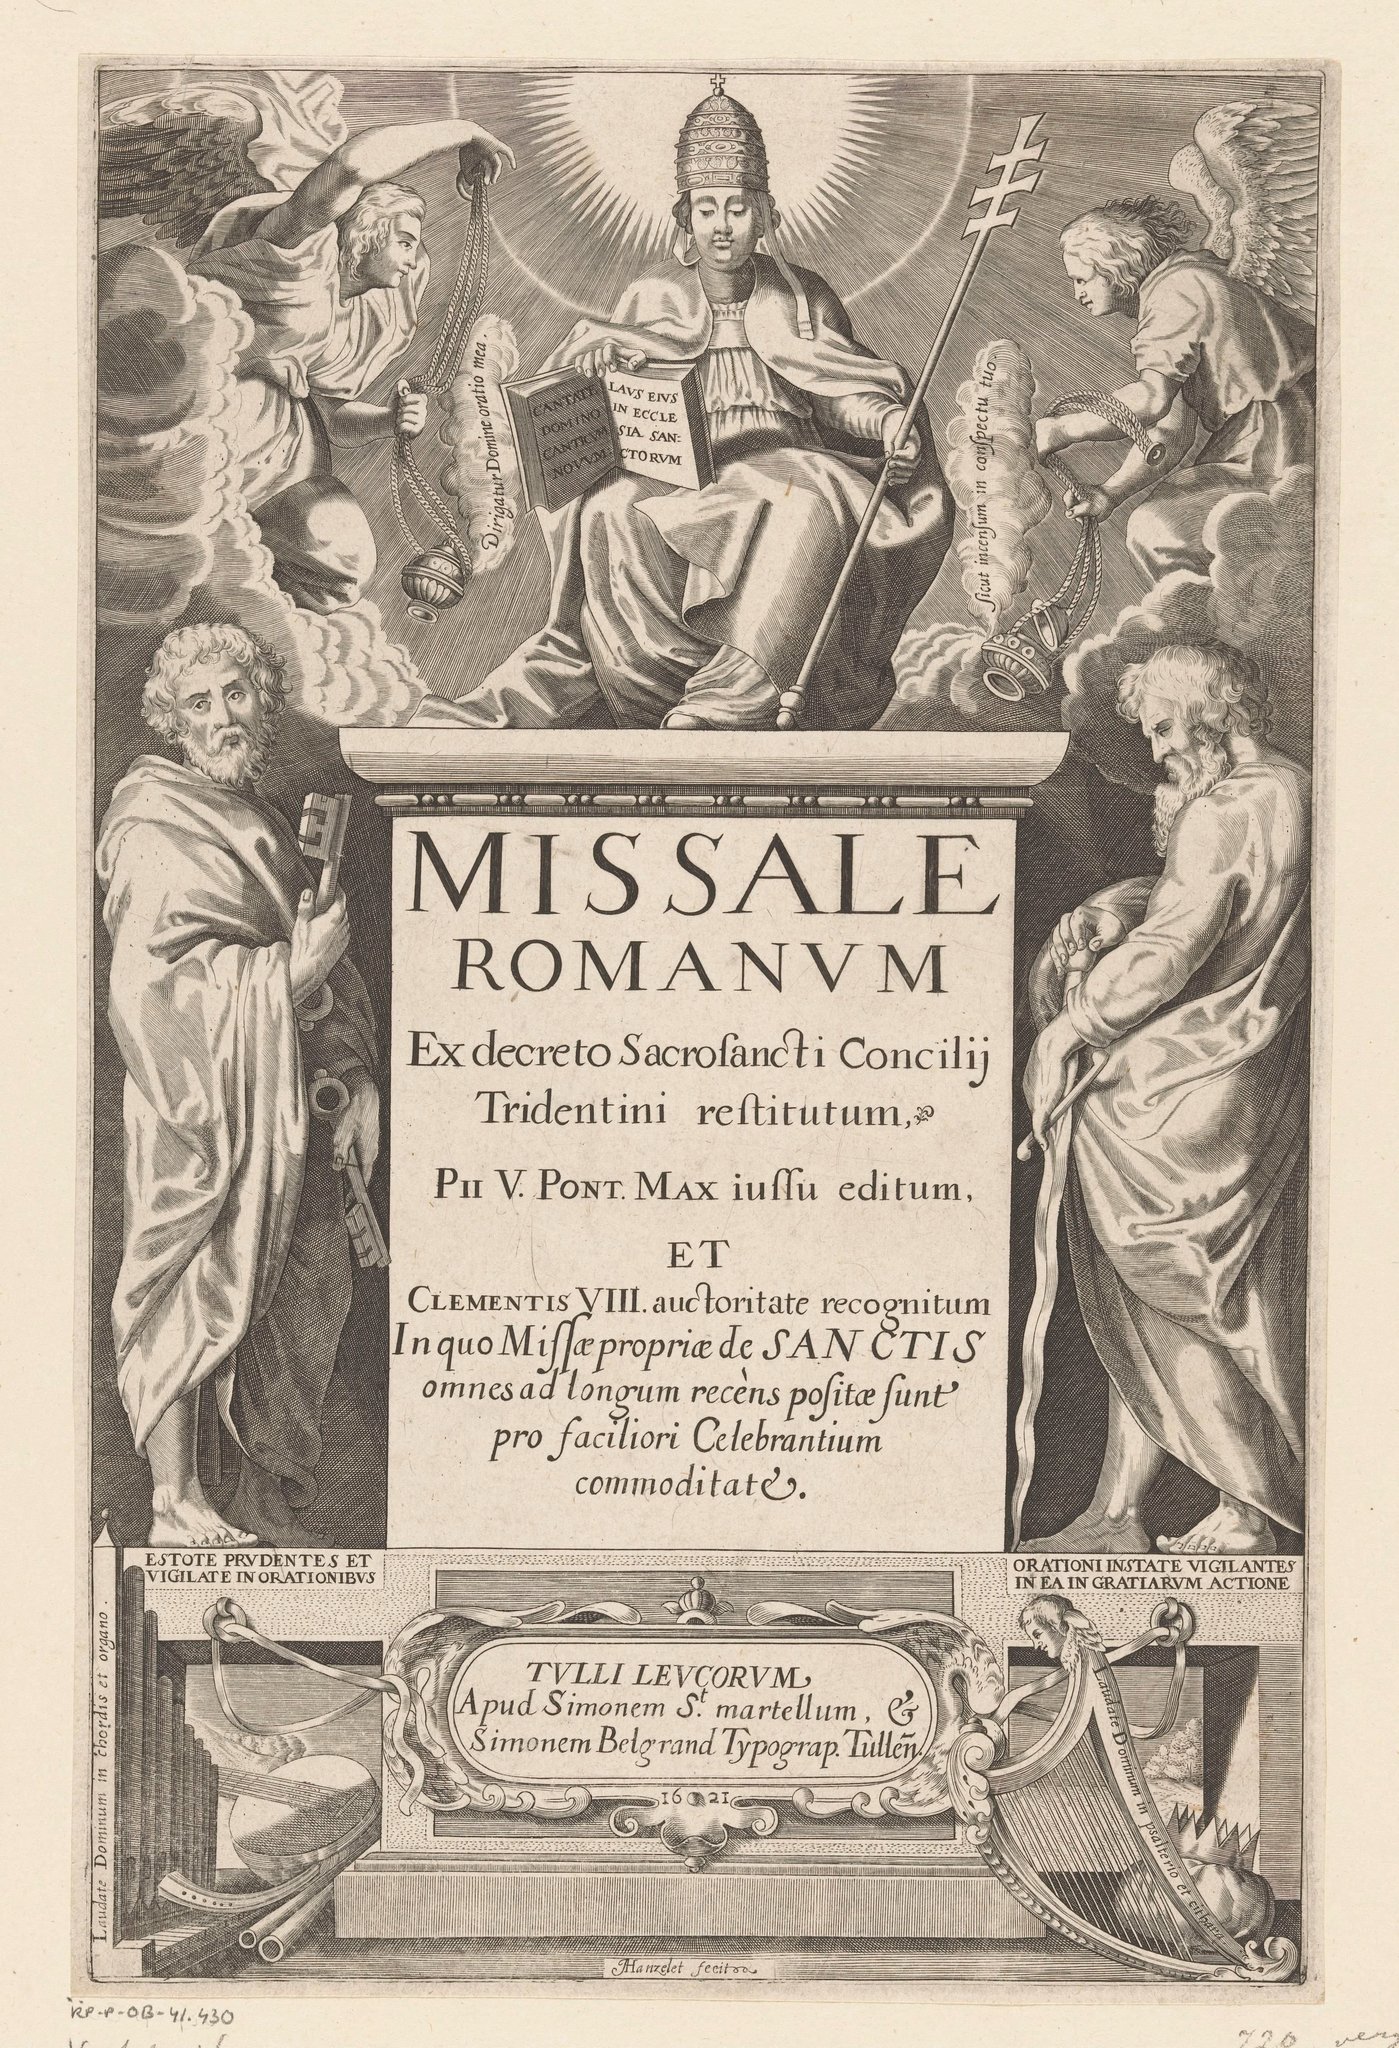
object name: titelblad, titelpagina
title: Titelpagina voor: Missale Romanum, 1621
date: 1621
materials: paper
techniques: engraving, etching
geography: toul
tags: pope, angels, the apostle peter, first bishop of rome; possible attributes: book, cock, (upturned) cross, (triple) crozier, fish, key, scroll, ship, tiara, the apostle paul of tarsus; possible attributes: book, scroll, sword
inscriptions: collector's mark: Lugt 240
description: Titelpagina voor: Missale Romanum. Toul: Simonem St. Martellum, Simon Belgrand, 1621.